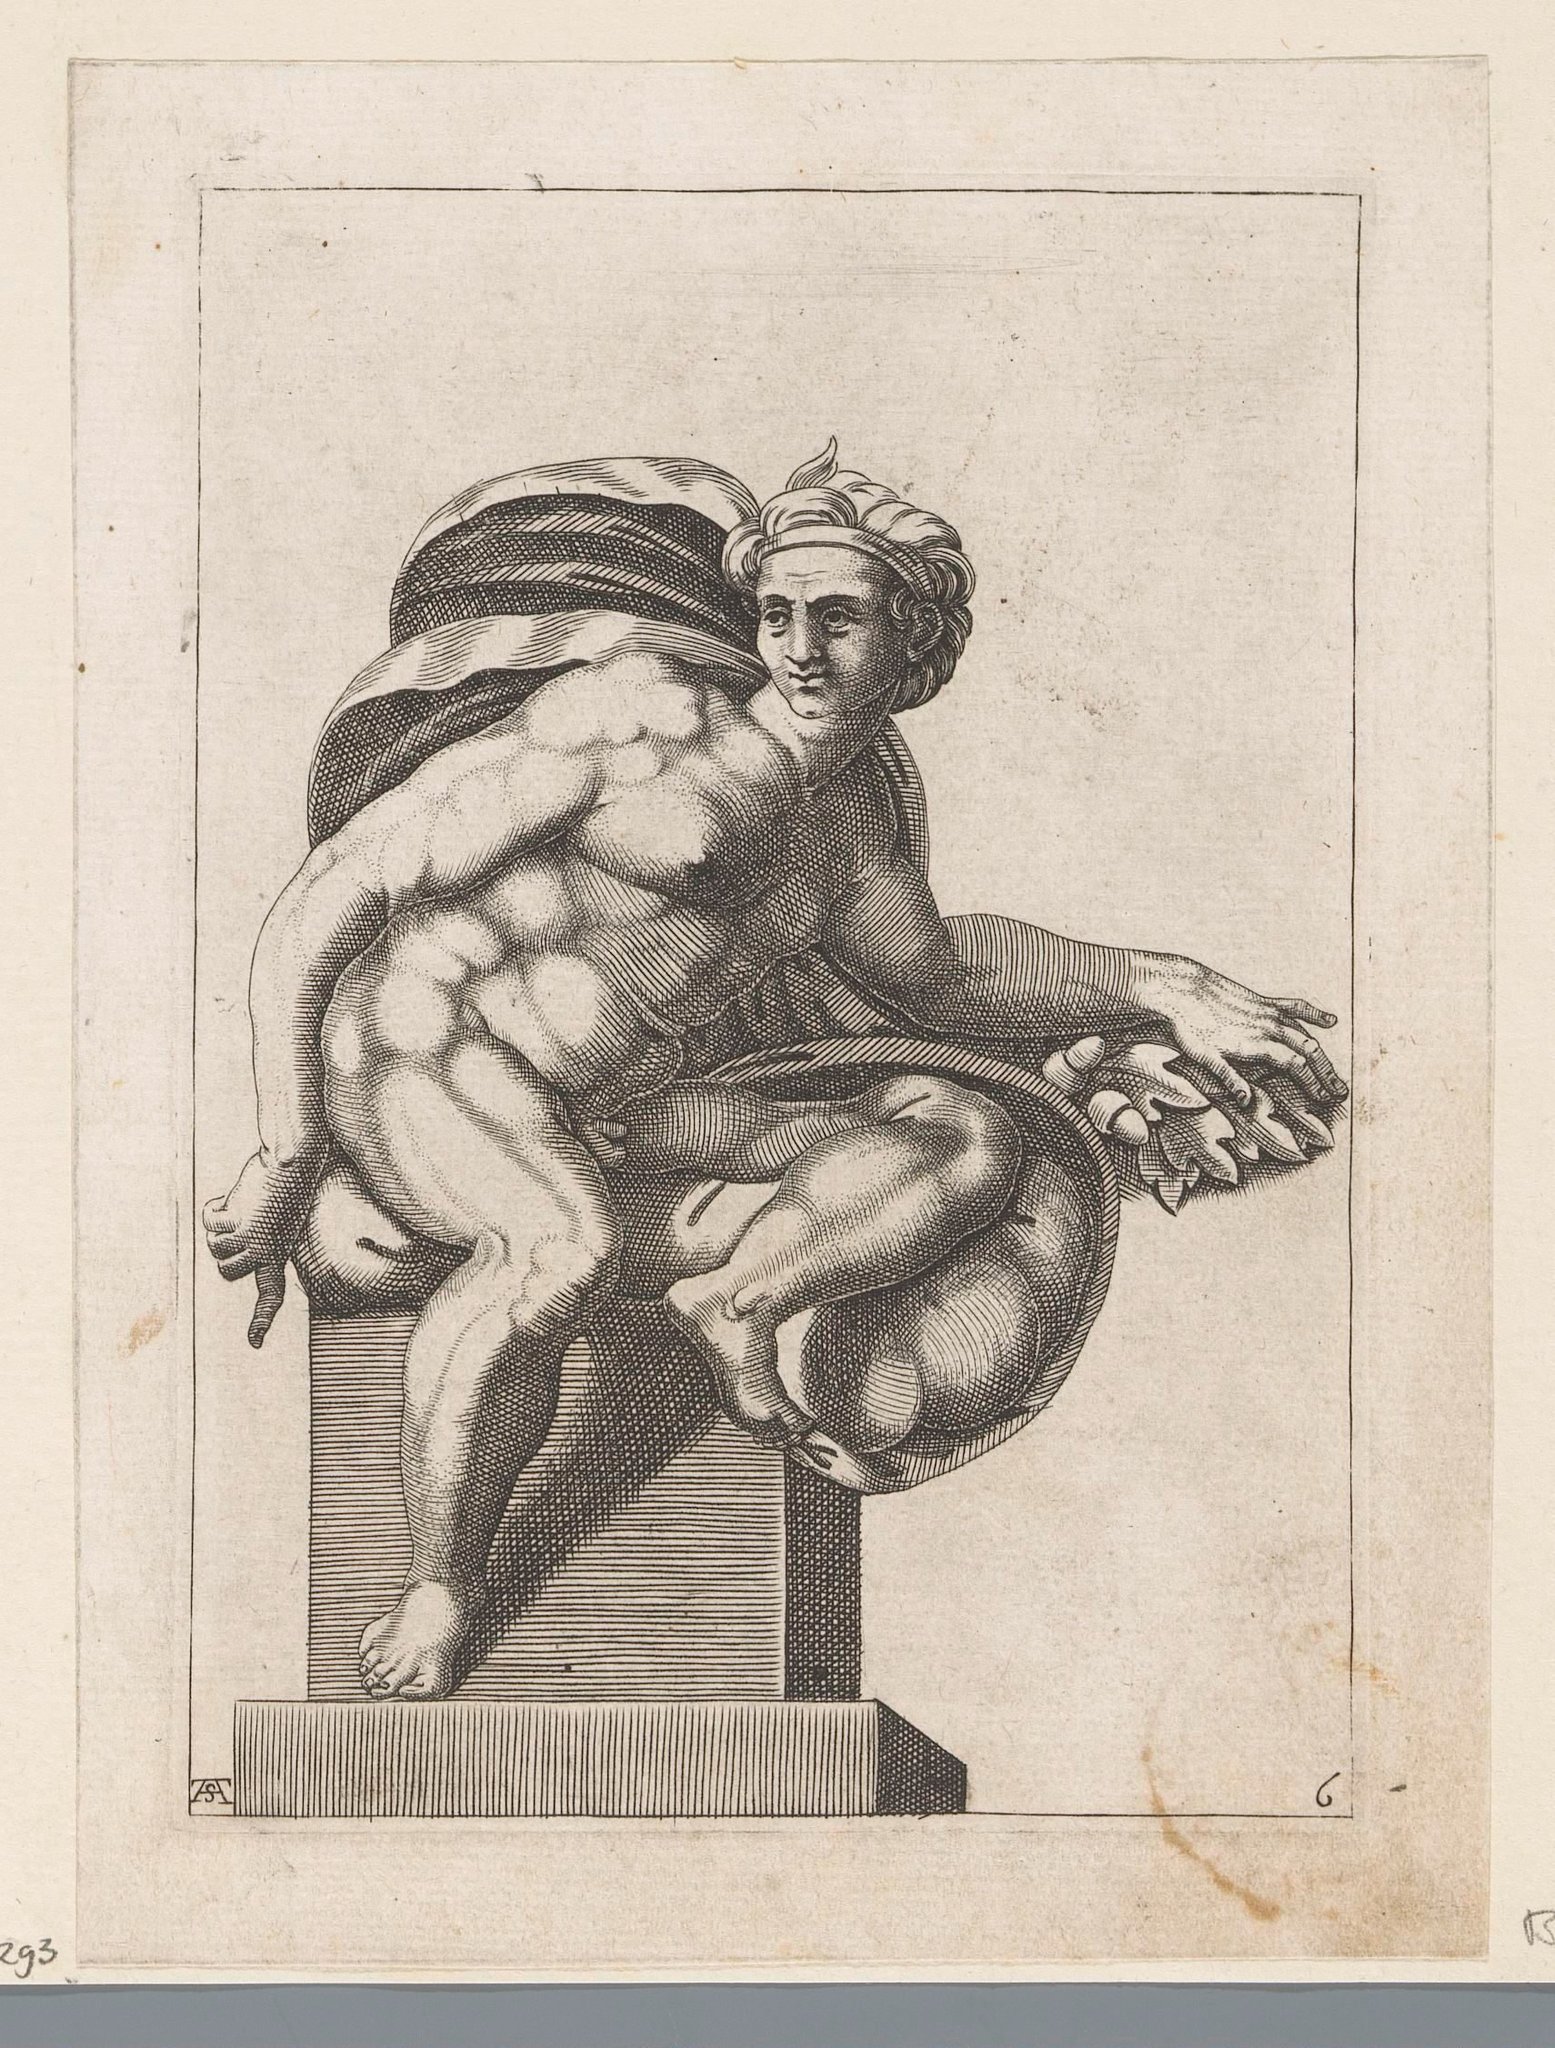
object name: print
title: Zittend naakt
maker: adamo scultori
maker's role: painter, print maker, sculptor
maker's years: 1530-1585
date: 1585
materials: paper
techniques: engraving, intaglio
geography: italy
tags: the (nude) human figure; 'corpo humano' (ripa), fruits: acorn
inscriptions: collector's mark: Lugt 240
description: Zittende naakte man, naar rechts gedraaid, met een guirlande van eikels. Eén van de 'ignudi' (naakte mannen) van Michelangelo's plafondschildering. Genummerd rechtsonder: 6.